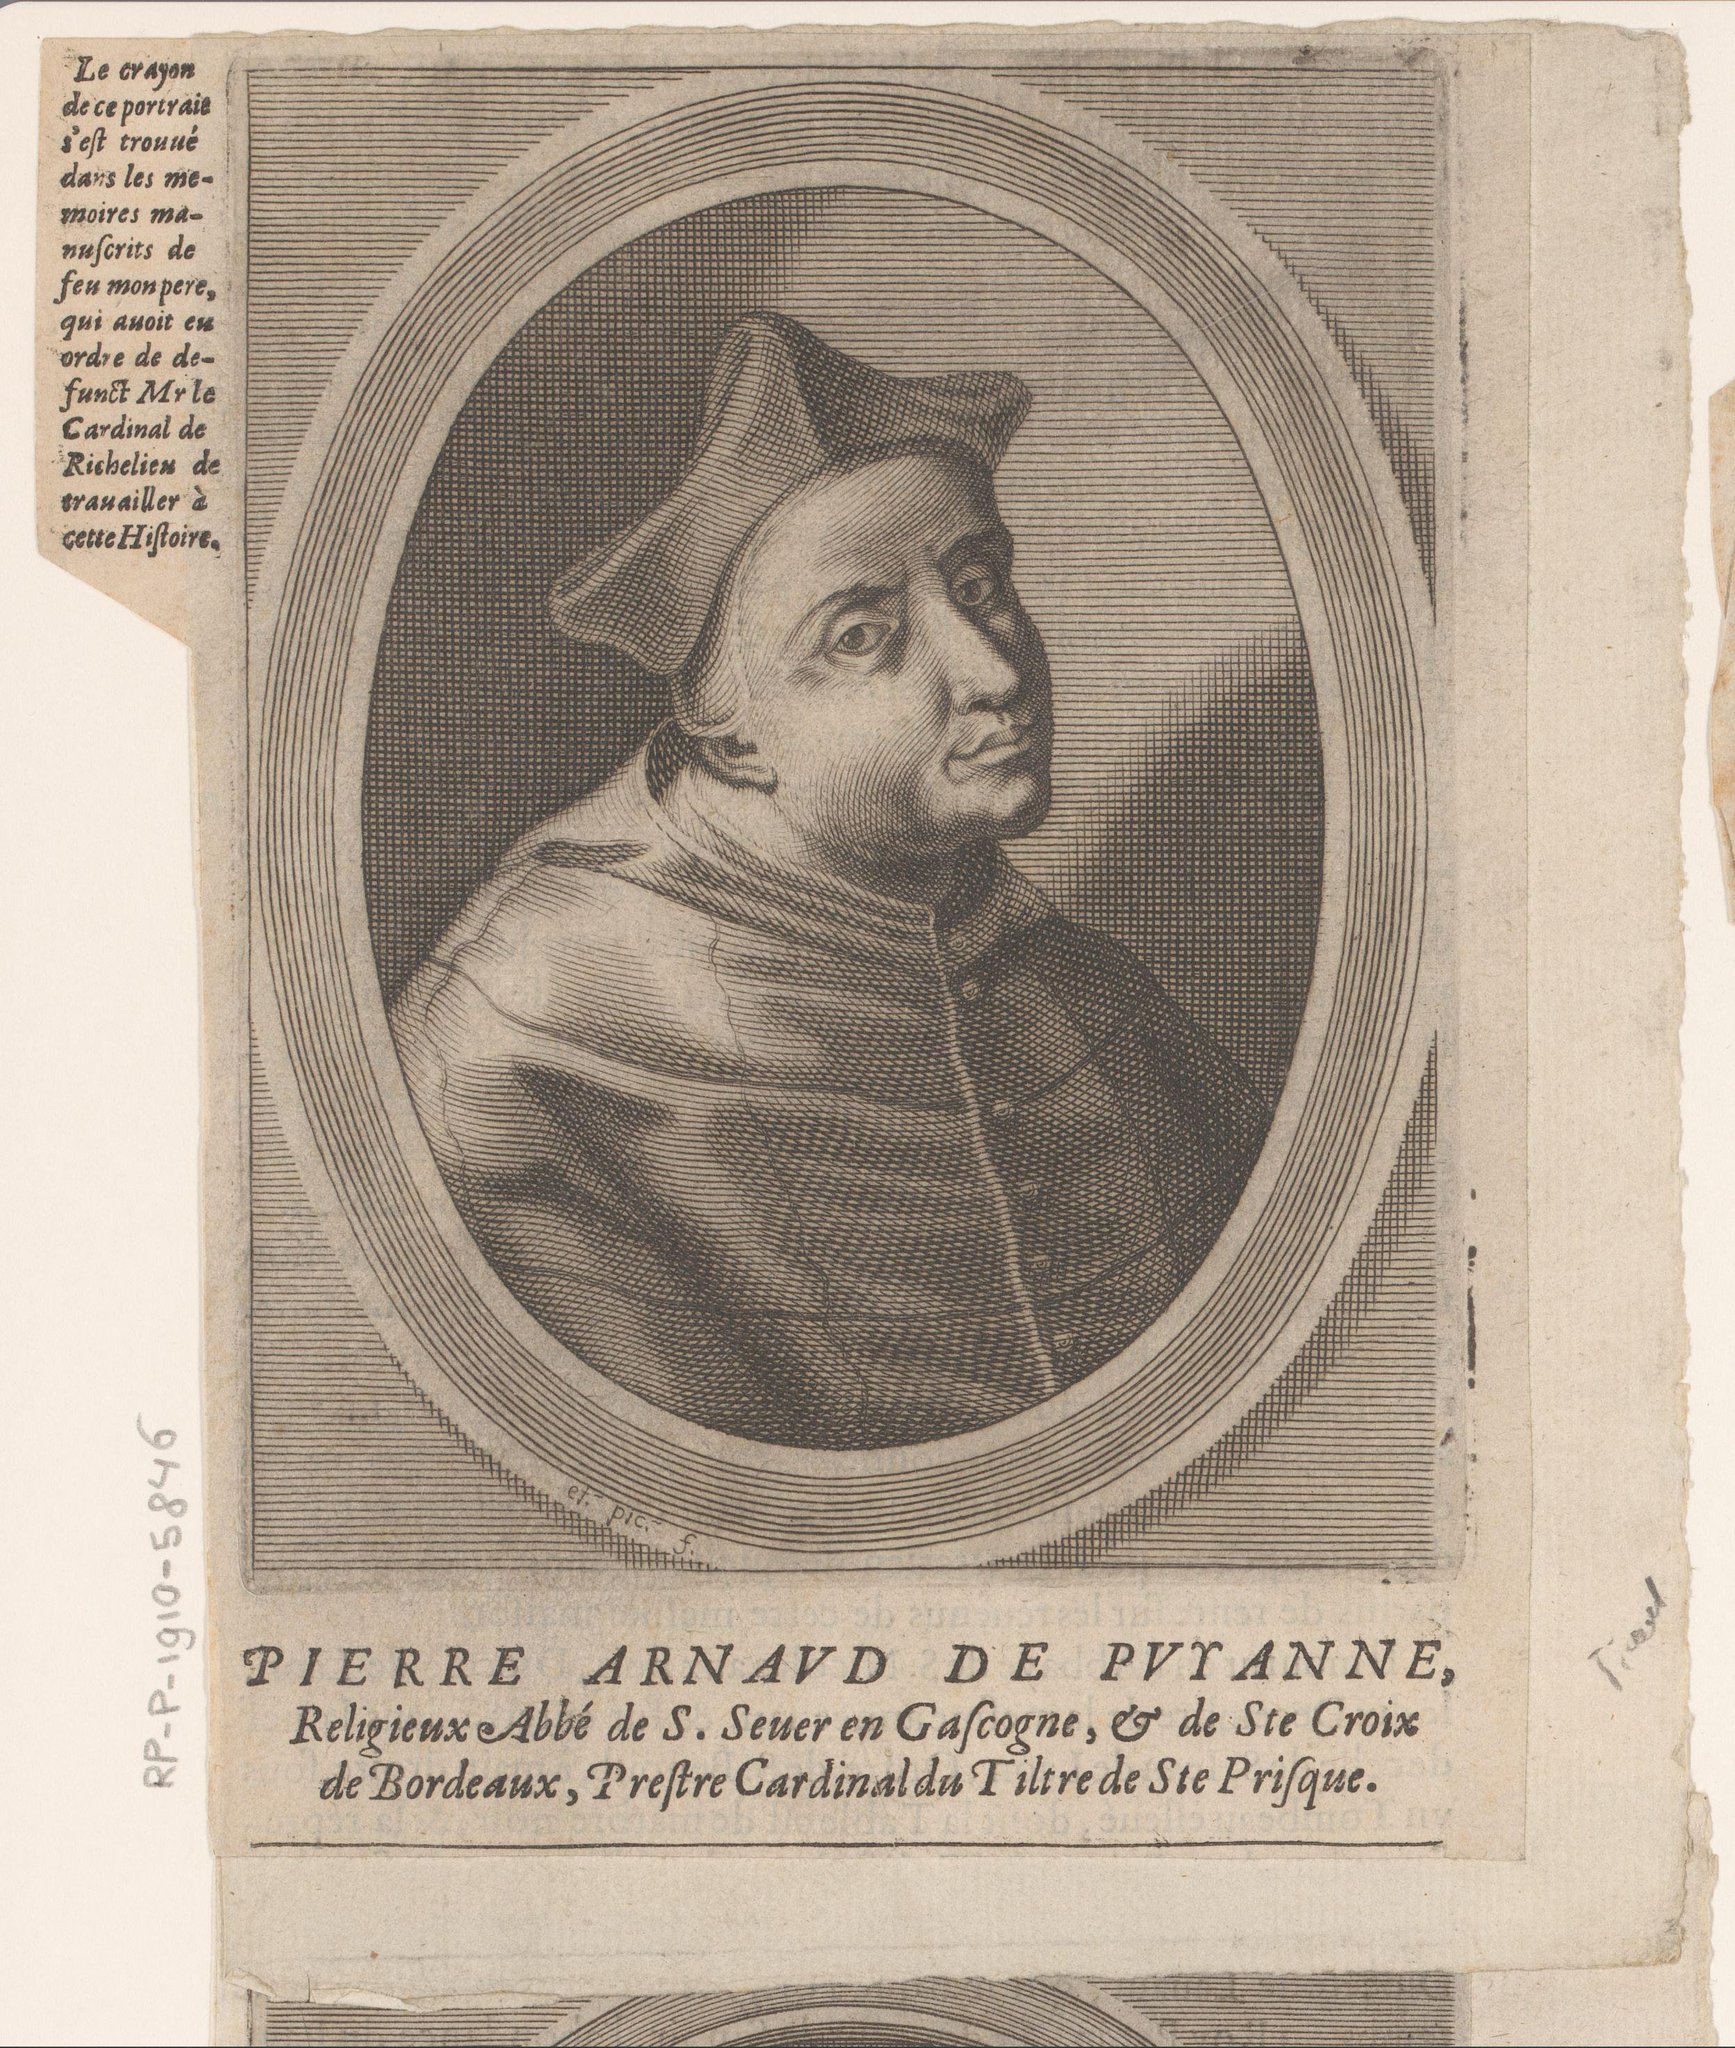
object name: book illustration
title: Portret van Pierre Arnaud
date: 1660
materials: paper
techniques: engraving, etching, letterpress printing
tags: cardinal, historical persons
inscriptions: collector's mark: Lugt 2228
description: Prent uit: Du Chesne, François. Histoire de tous les cardinaux françois de naissance, ou qui ont esté promeus au cardinalat. Parijs: François Du Chesne, 1660.